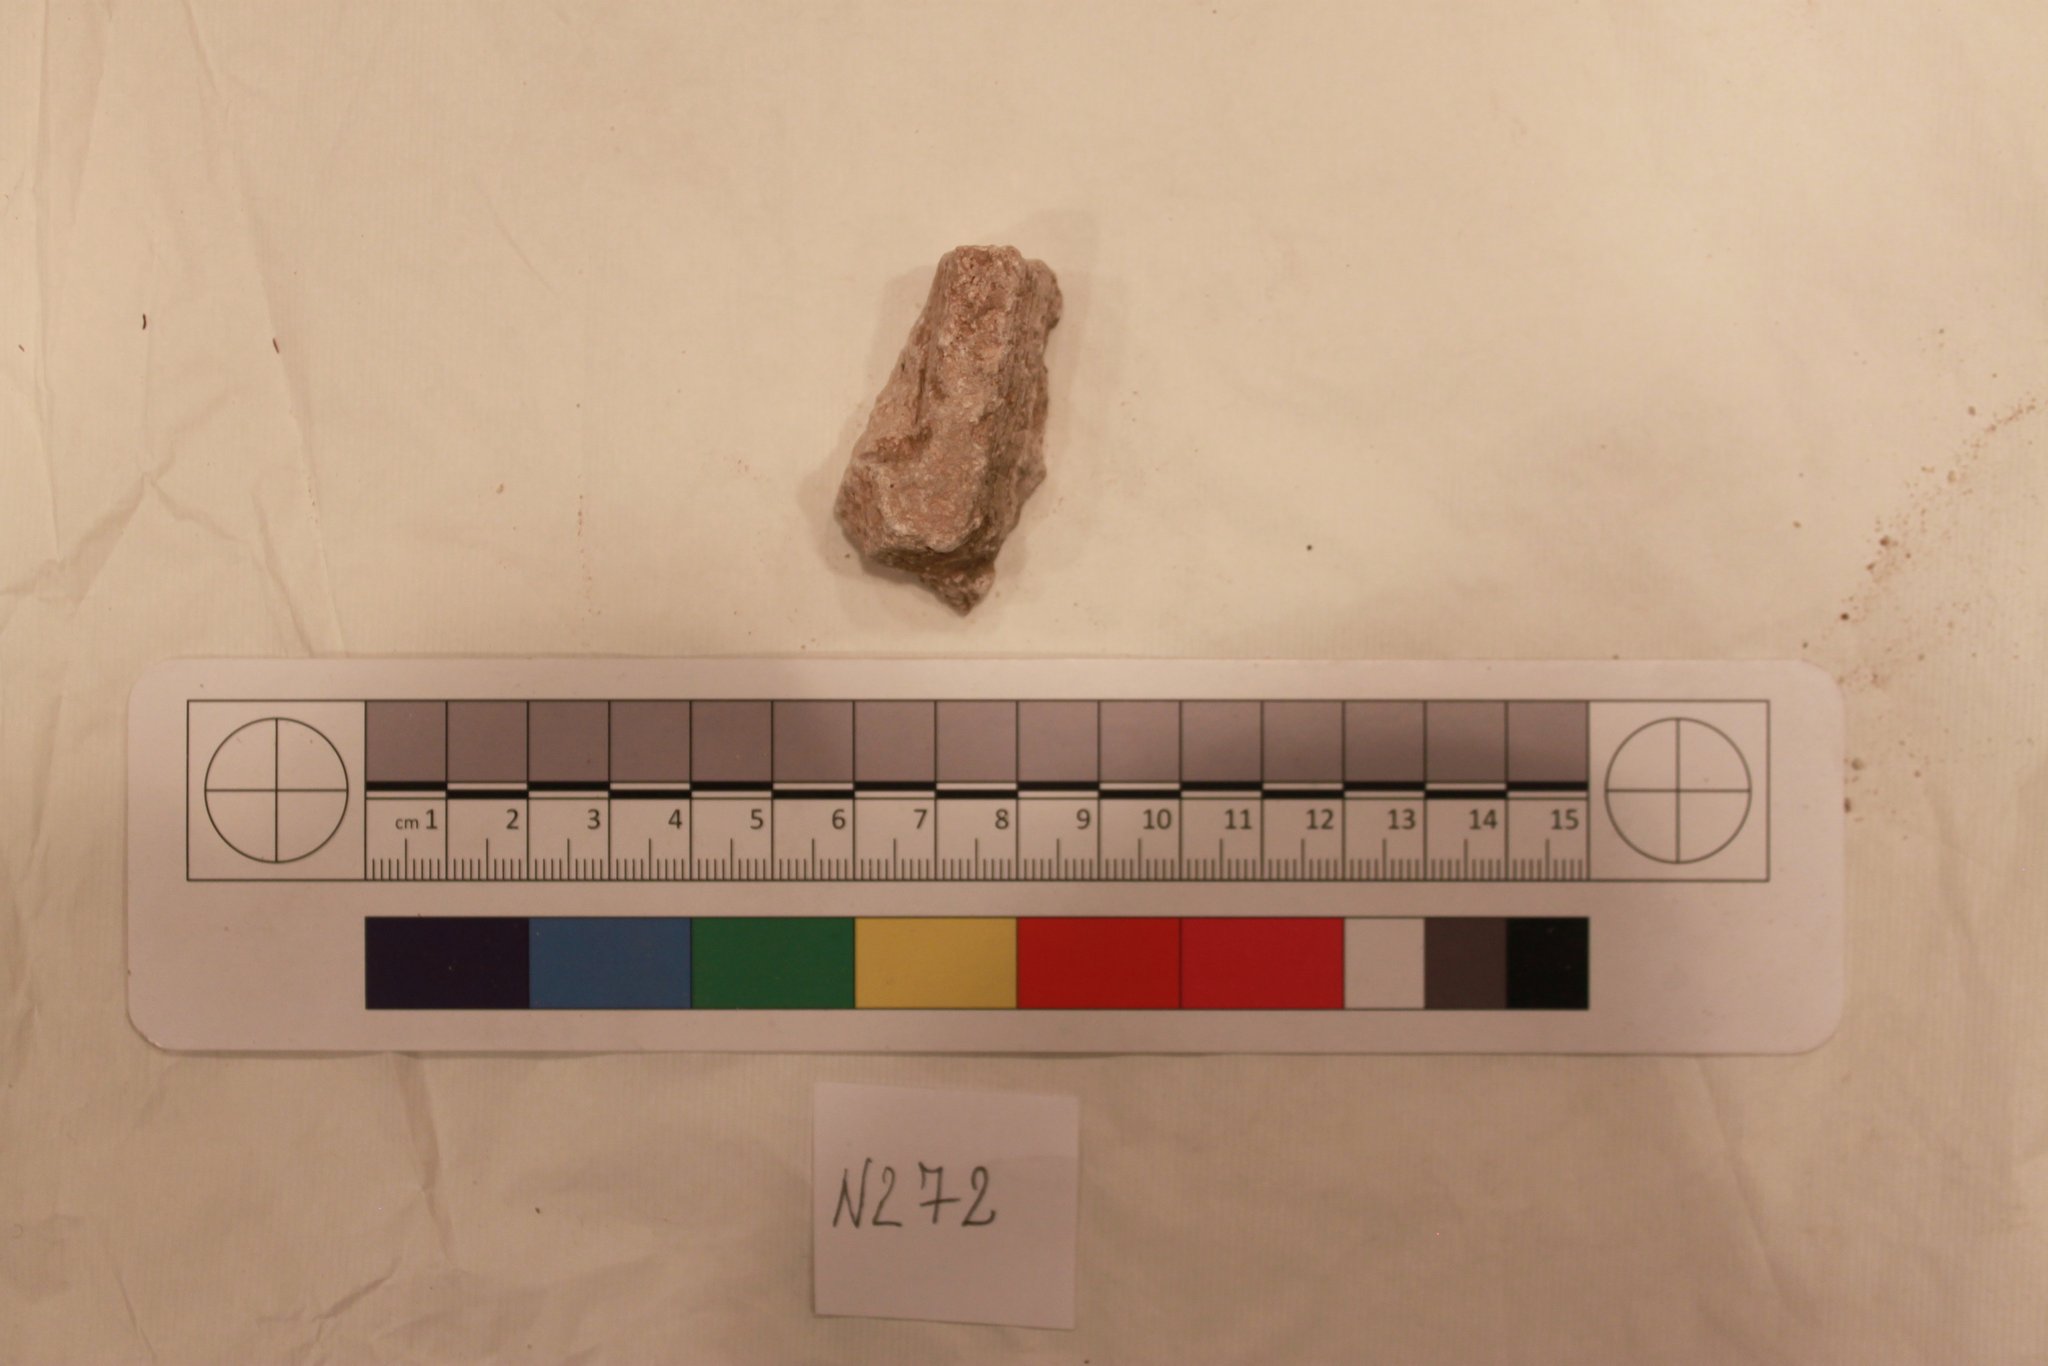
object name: fragment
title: Stucco Fragment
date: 701-1200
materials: plaster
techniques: carving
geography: iran